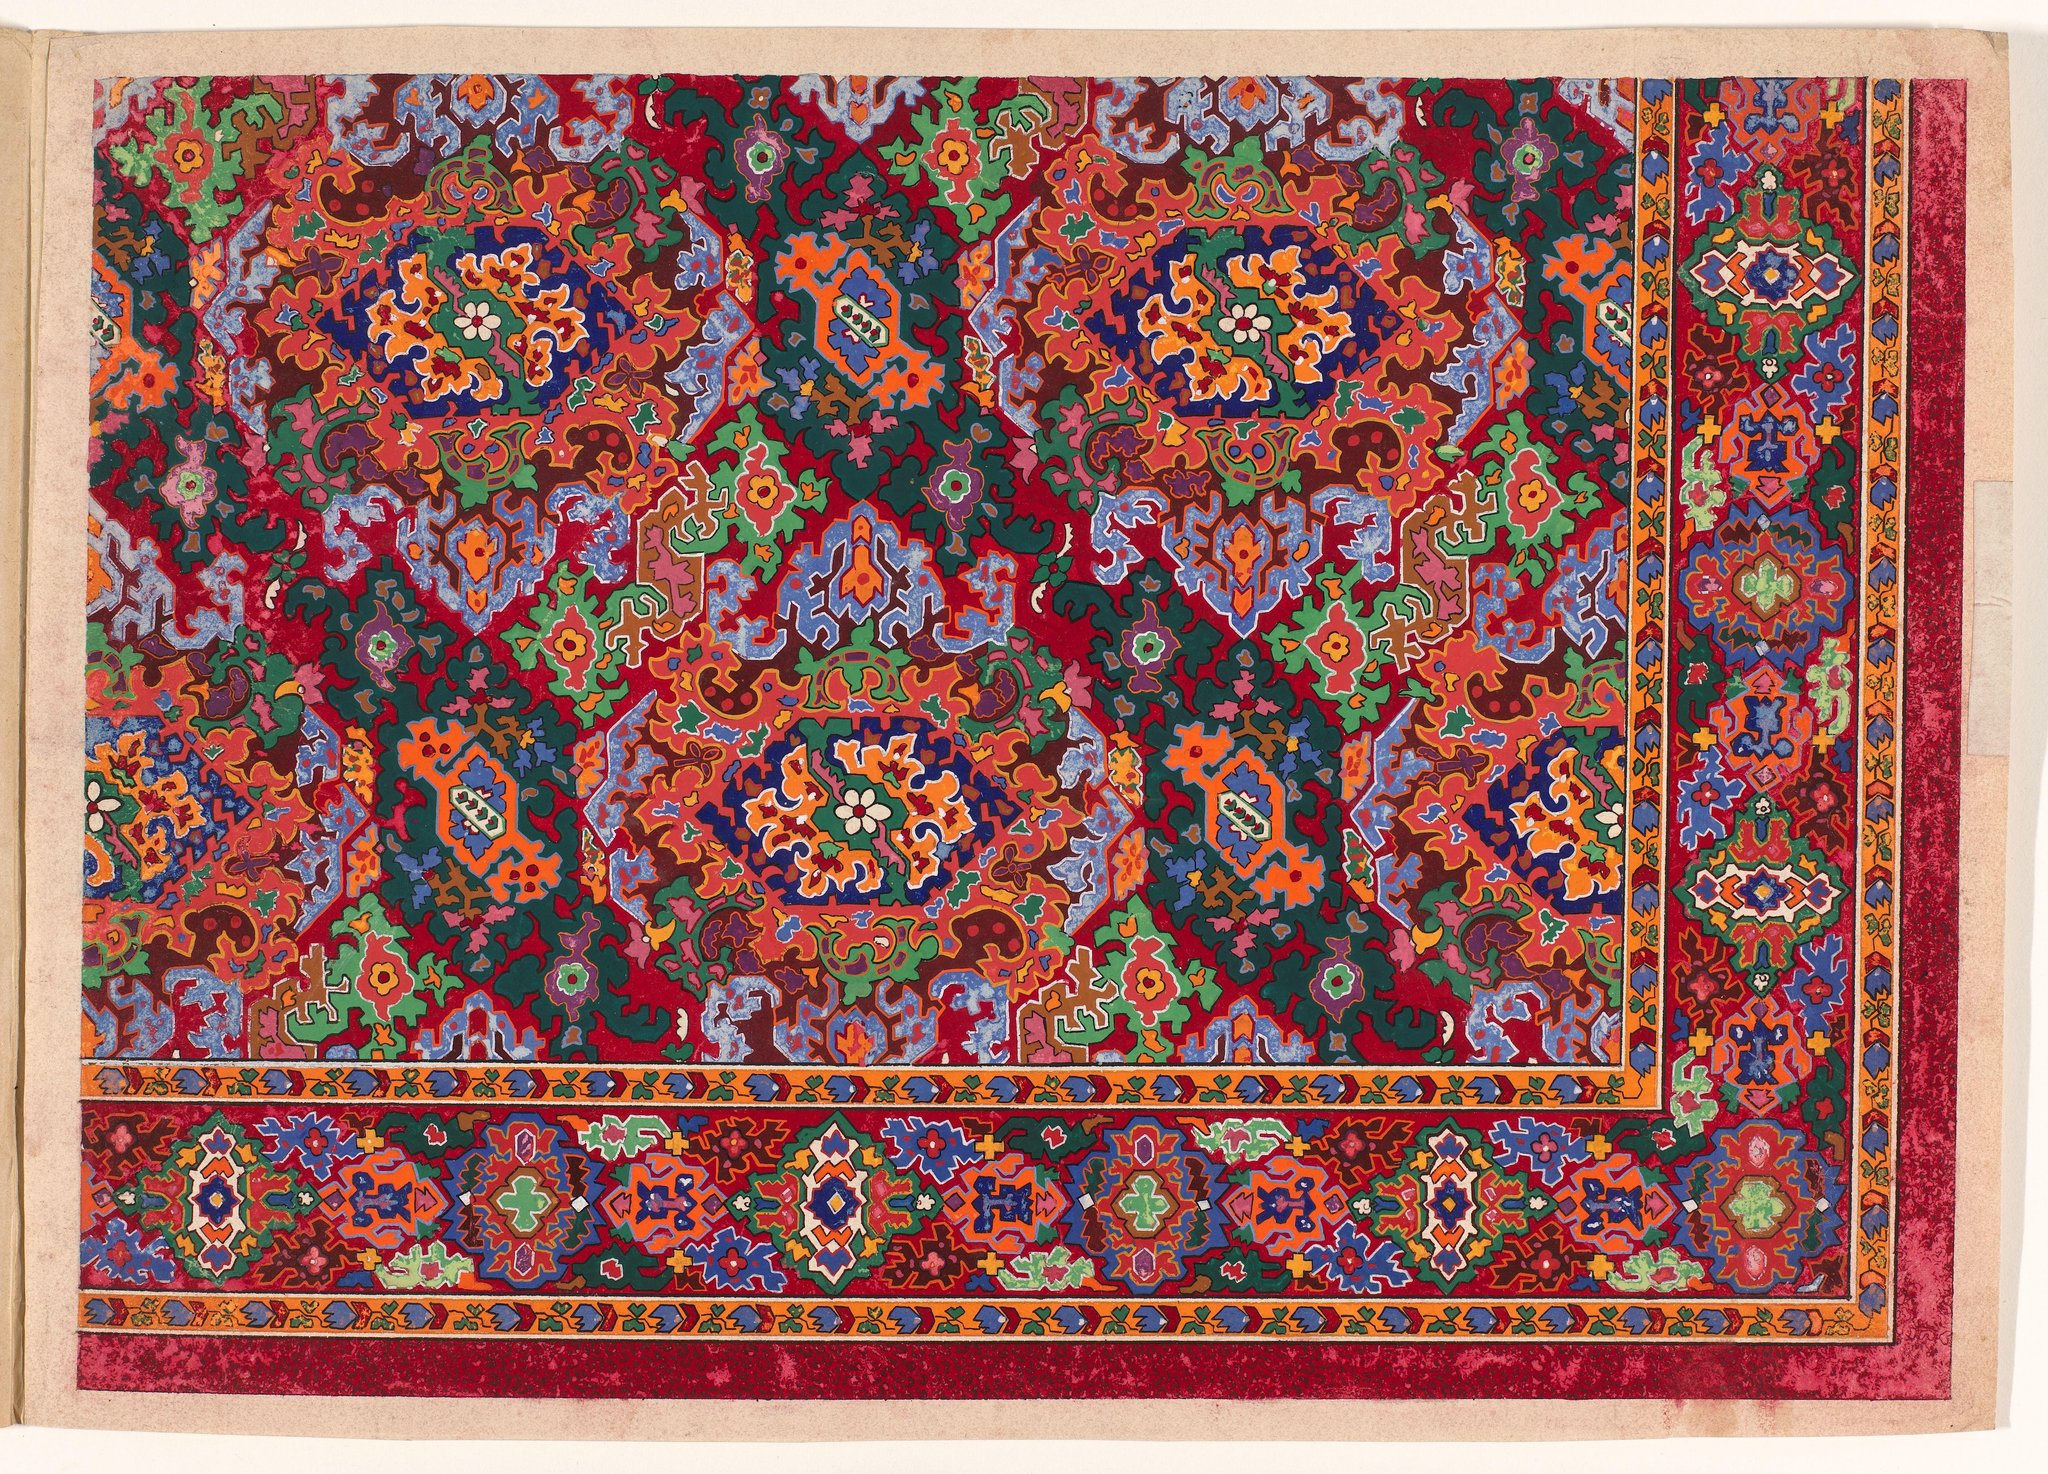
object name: drawing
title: Ontwerp voor een tapijt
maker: Anonymous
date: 1854-1864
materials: gouache, paper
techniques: brush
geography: deventer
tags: ornaments ~ art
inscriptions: retailer's mark: ‘JHS.’, number: ‘No 363 A.’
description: De presentatietekeningen BK-1971-77-1 t/m 86 zijn kopieën van de originele ontwerptekeningen. Ze werden gemaakt voor vertegenwoordigers van bijvoorbeeld magazijnen, die ze aan hun klanten konden tonen. De meeste tekeningen tonen een kwart van het dessin inclusief rand, middenpartij (de zogenaamde grond of fond) en centraal medaillon. Door het gebruik van spiegels kan de illusie van het gehele tapijt worden opgeroepen. Een deel van de tekeningen heeft een alfabetische opeenvolgende letter als kenmerk, de andere groep een cijfer.Waarschijnlijk is de reeks dessins met een letter eerder samengesteld dan de genummerde tekeningen.